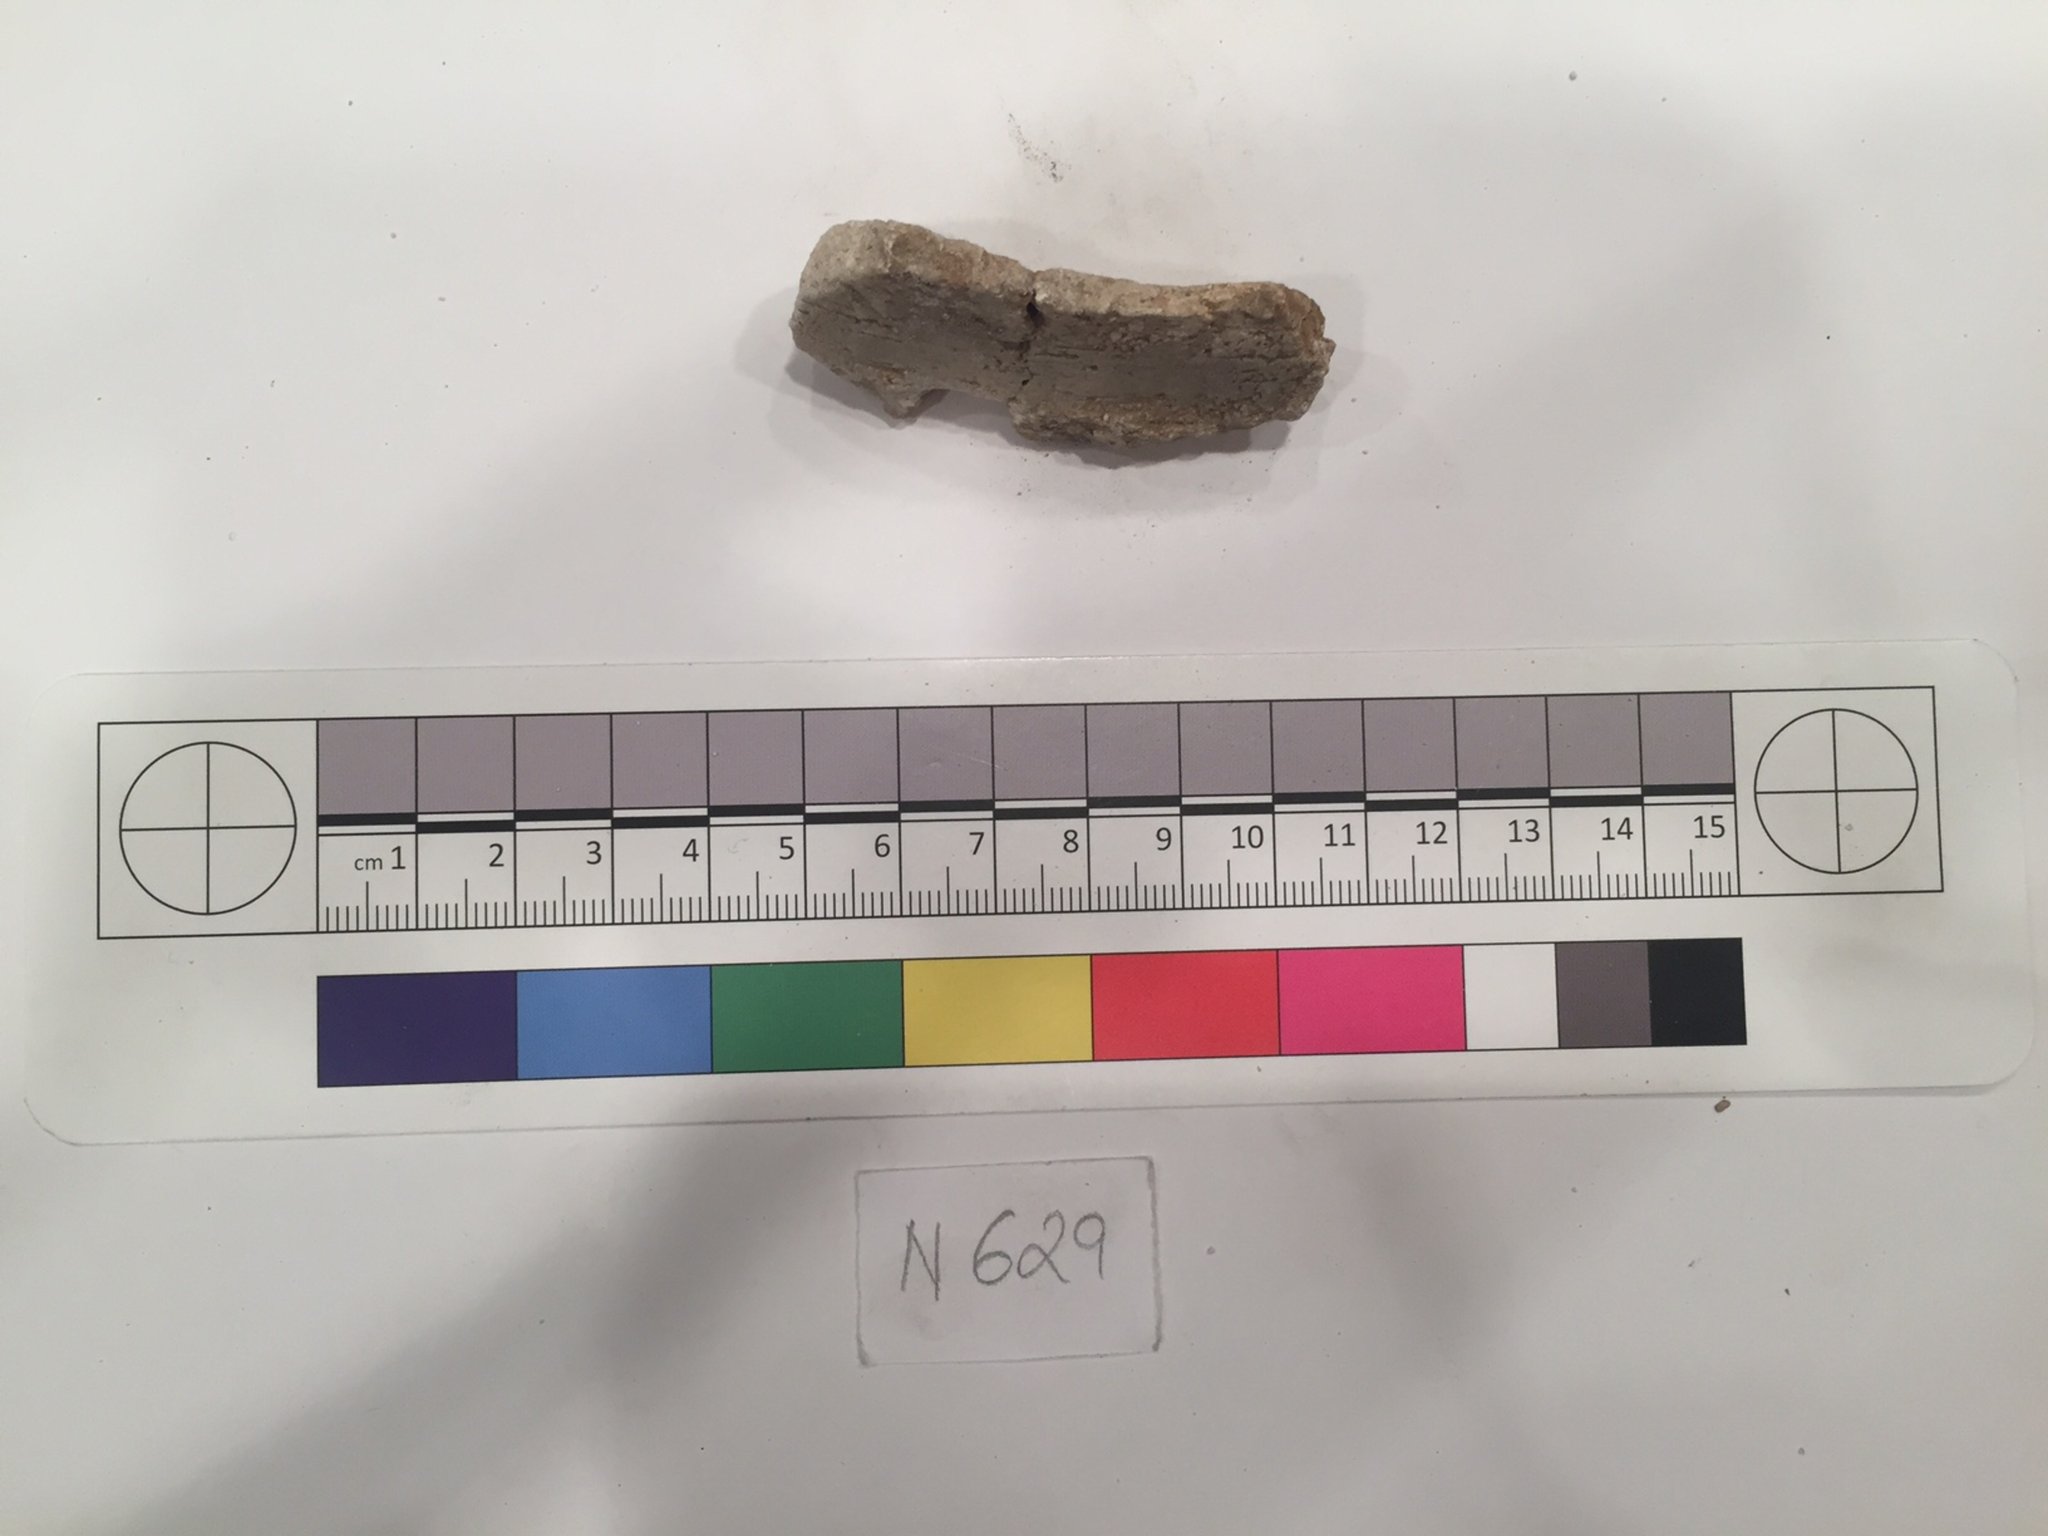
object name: fragment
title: Stucco Fragment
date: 701-1200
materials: plaster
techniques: carving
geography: iran